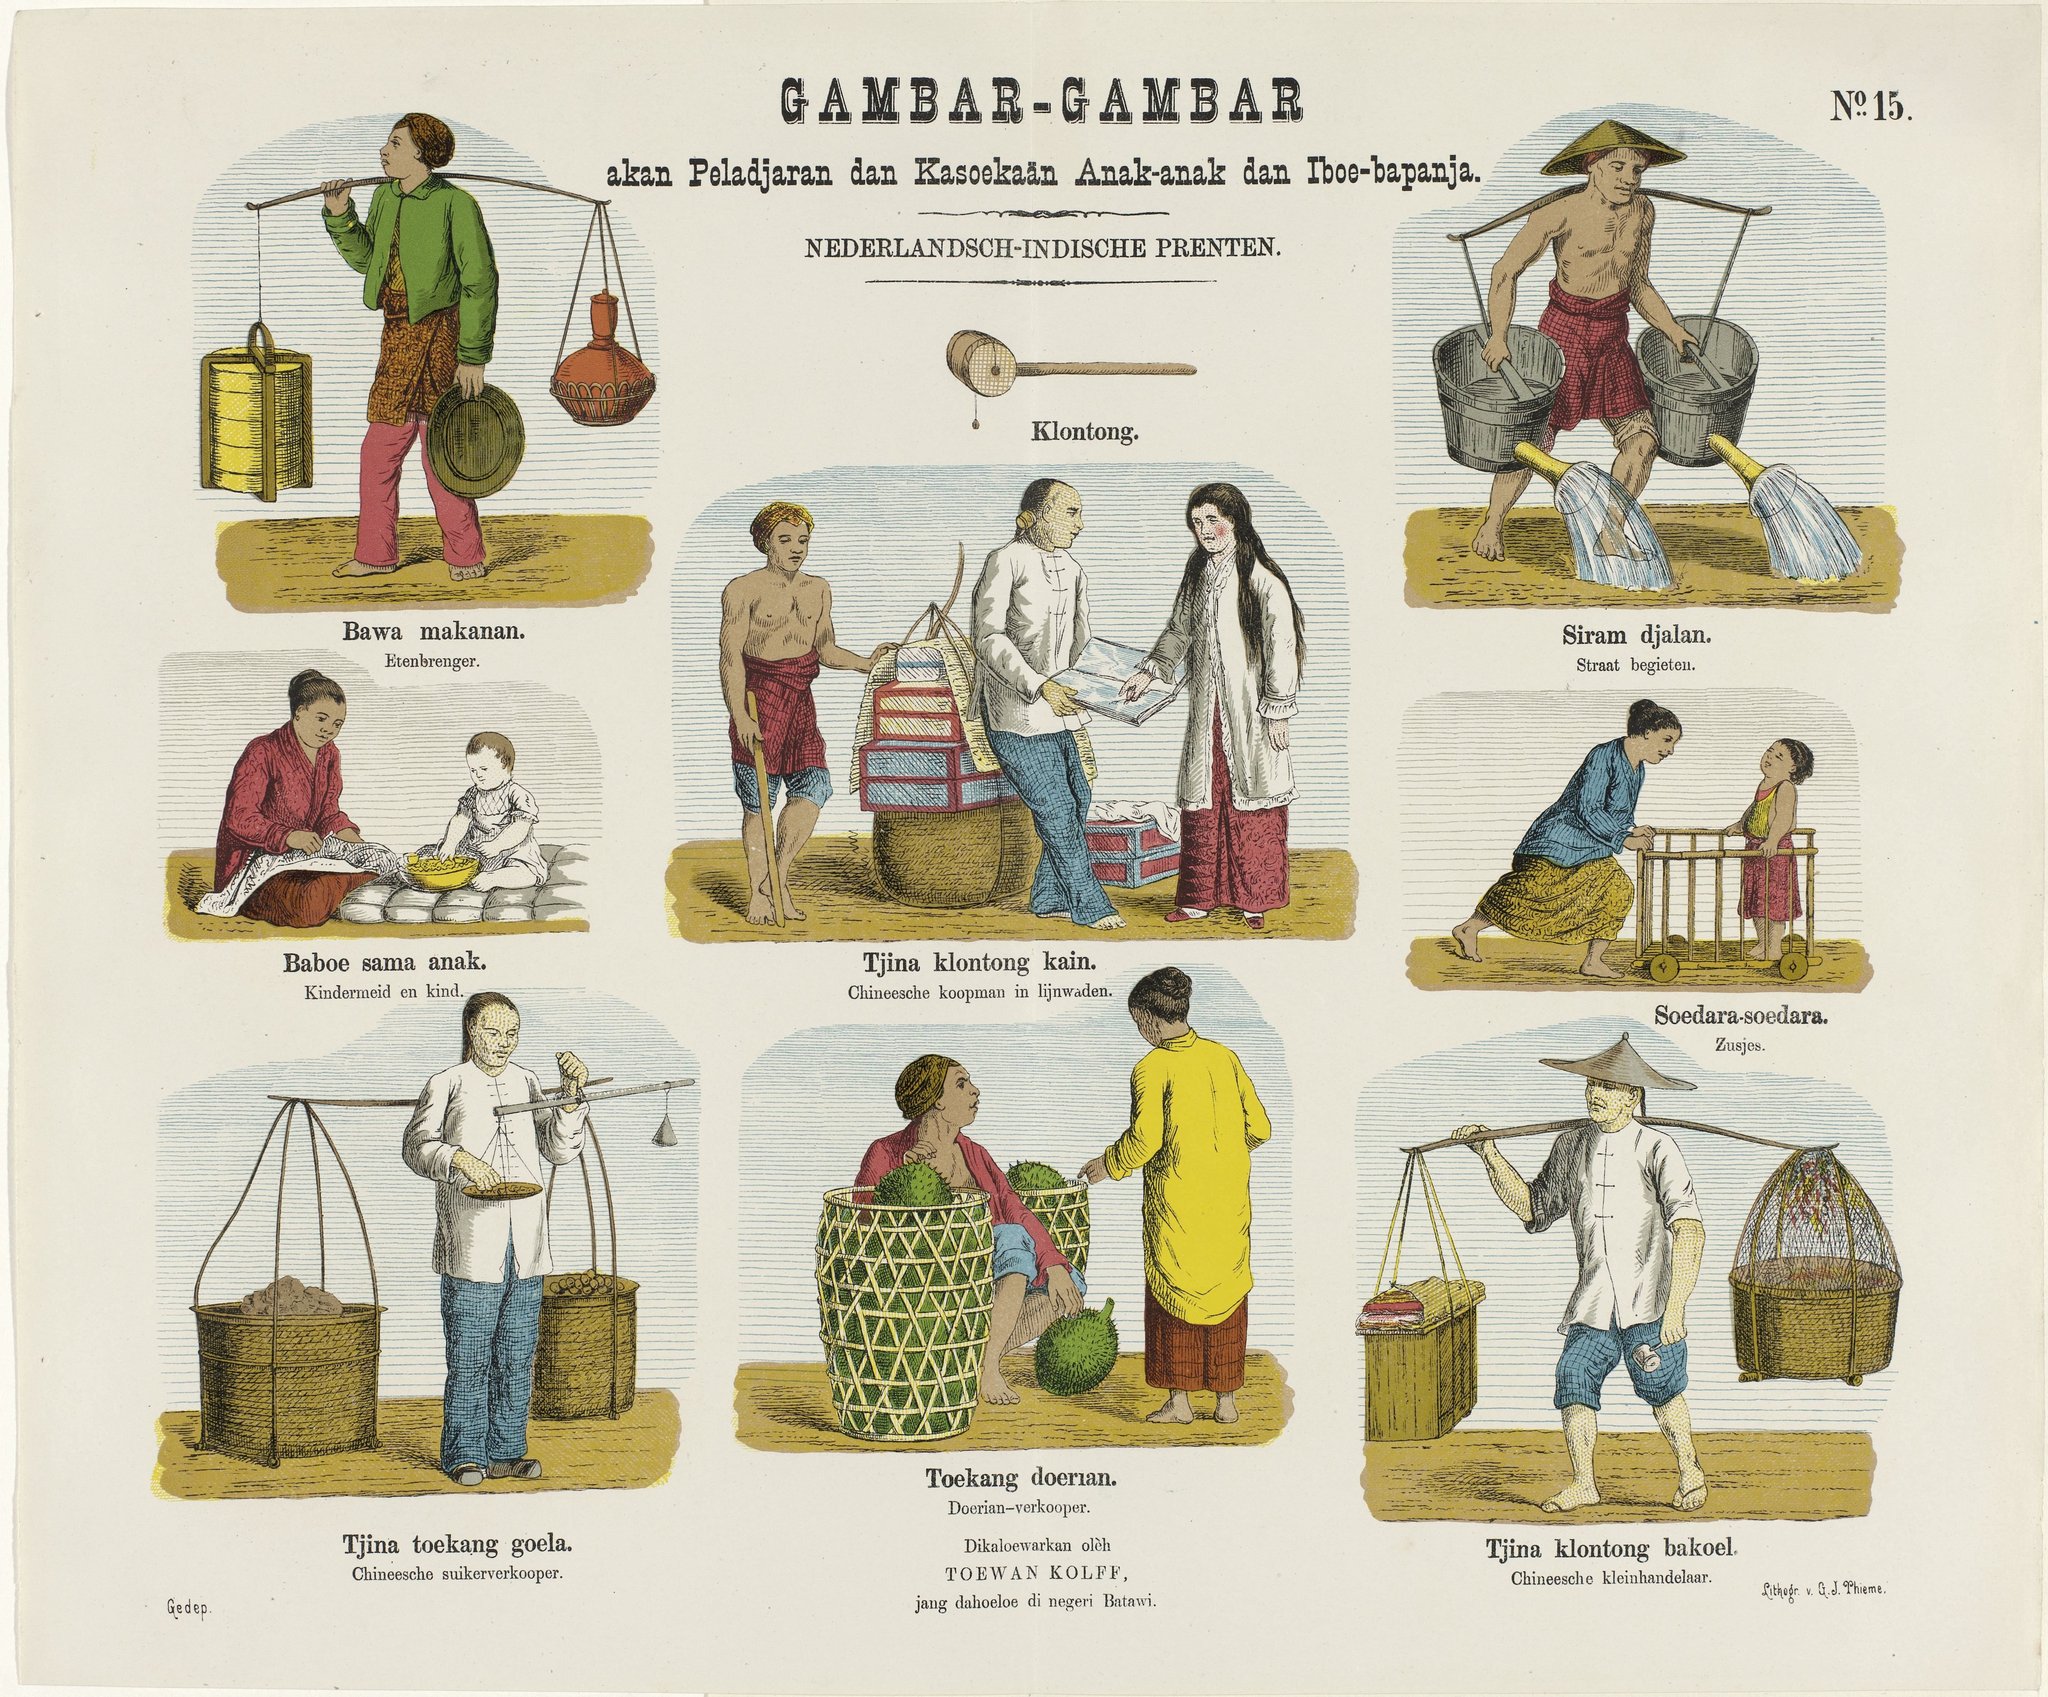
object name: popular print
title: Prenten tot nut en genoegen van jong en oud / Nederlandsch-Indische prenten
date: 1868-1881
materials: paper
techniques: lithograph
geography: arnhem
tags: asiatic races and peoples, street-trader, merchant, salesman, dutch east indies, the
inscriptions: collector's mark: Lugt 2760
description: Blad met acht voorstellingen van beroepen en figuren in de voormalige kolonie Nederlands-Indië, waaronder een koopman, een straatbegieter en een kindermeid. Onder elke afbeelding een onderschrift in het Maleis en het Nederlands. Genummerd rechtsboven: No. 15.